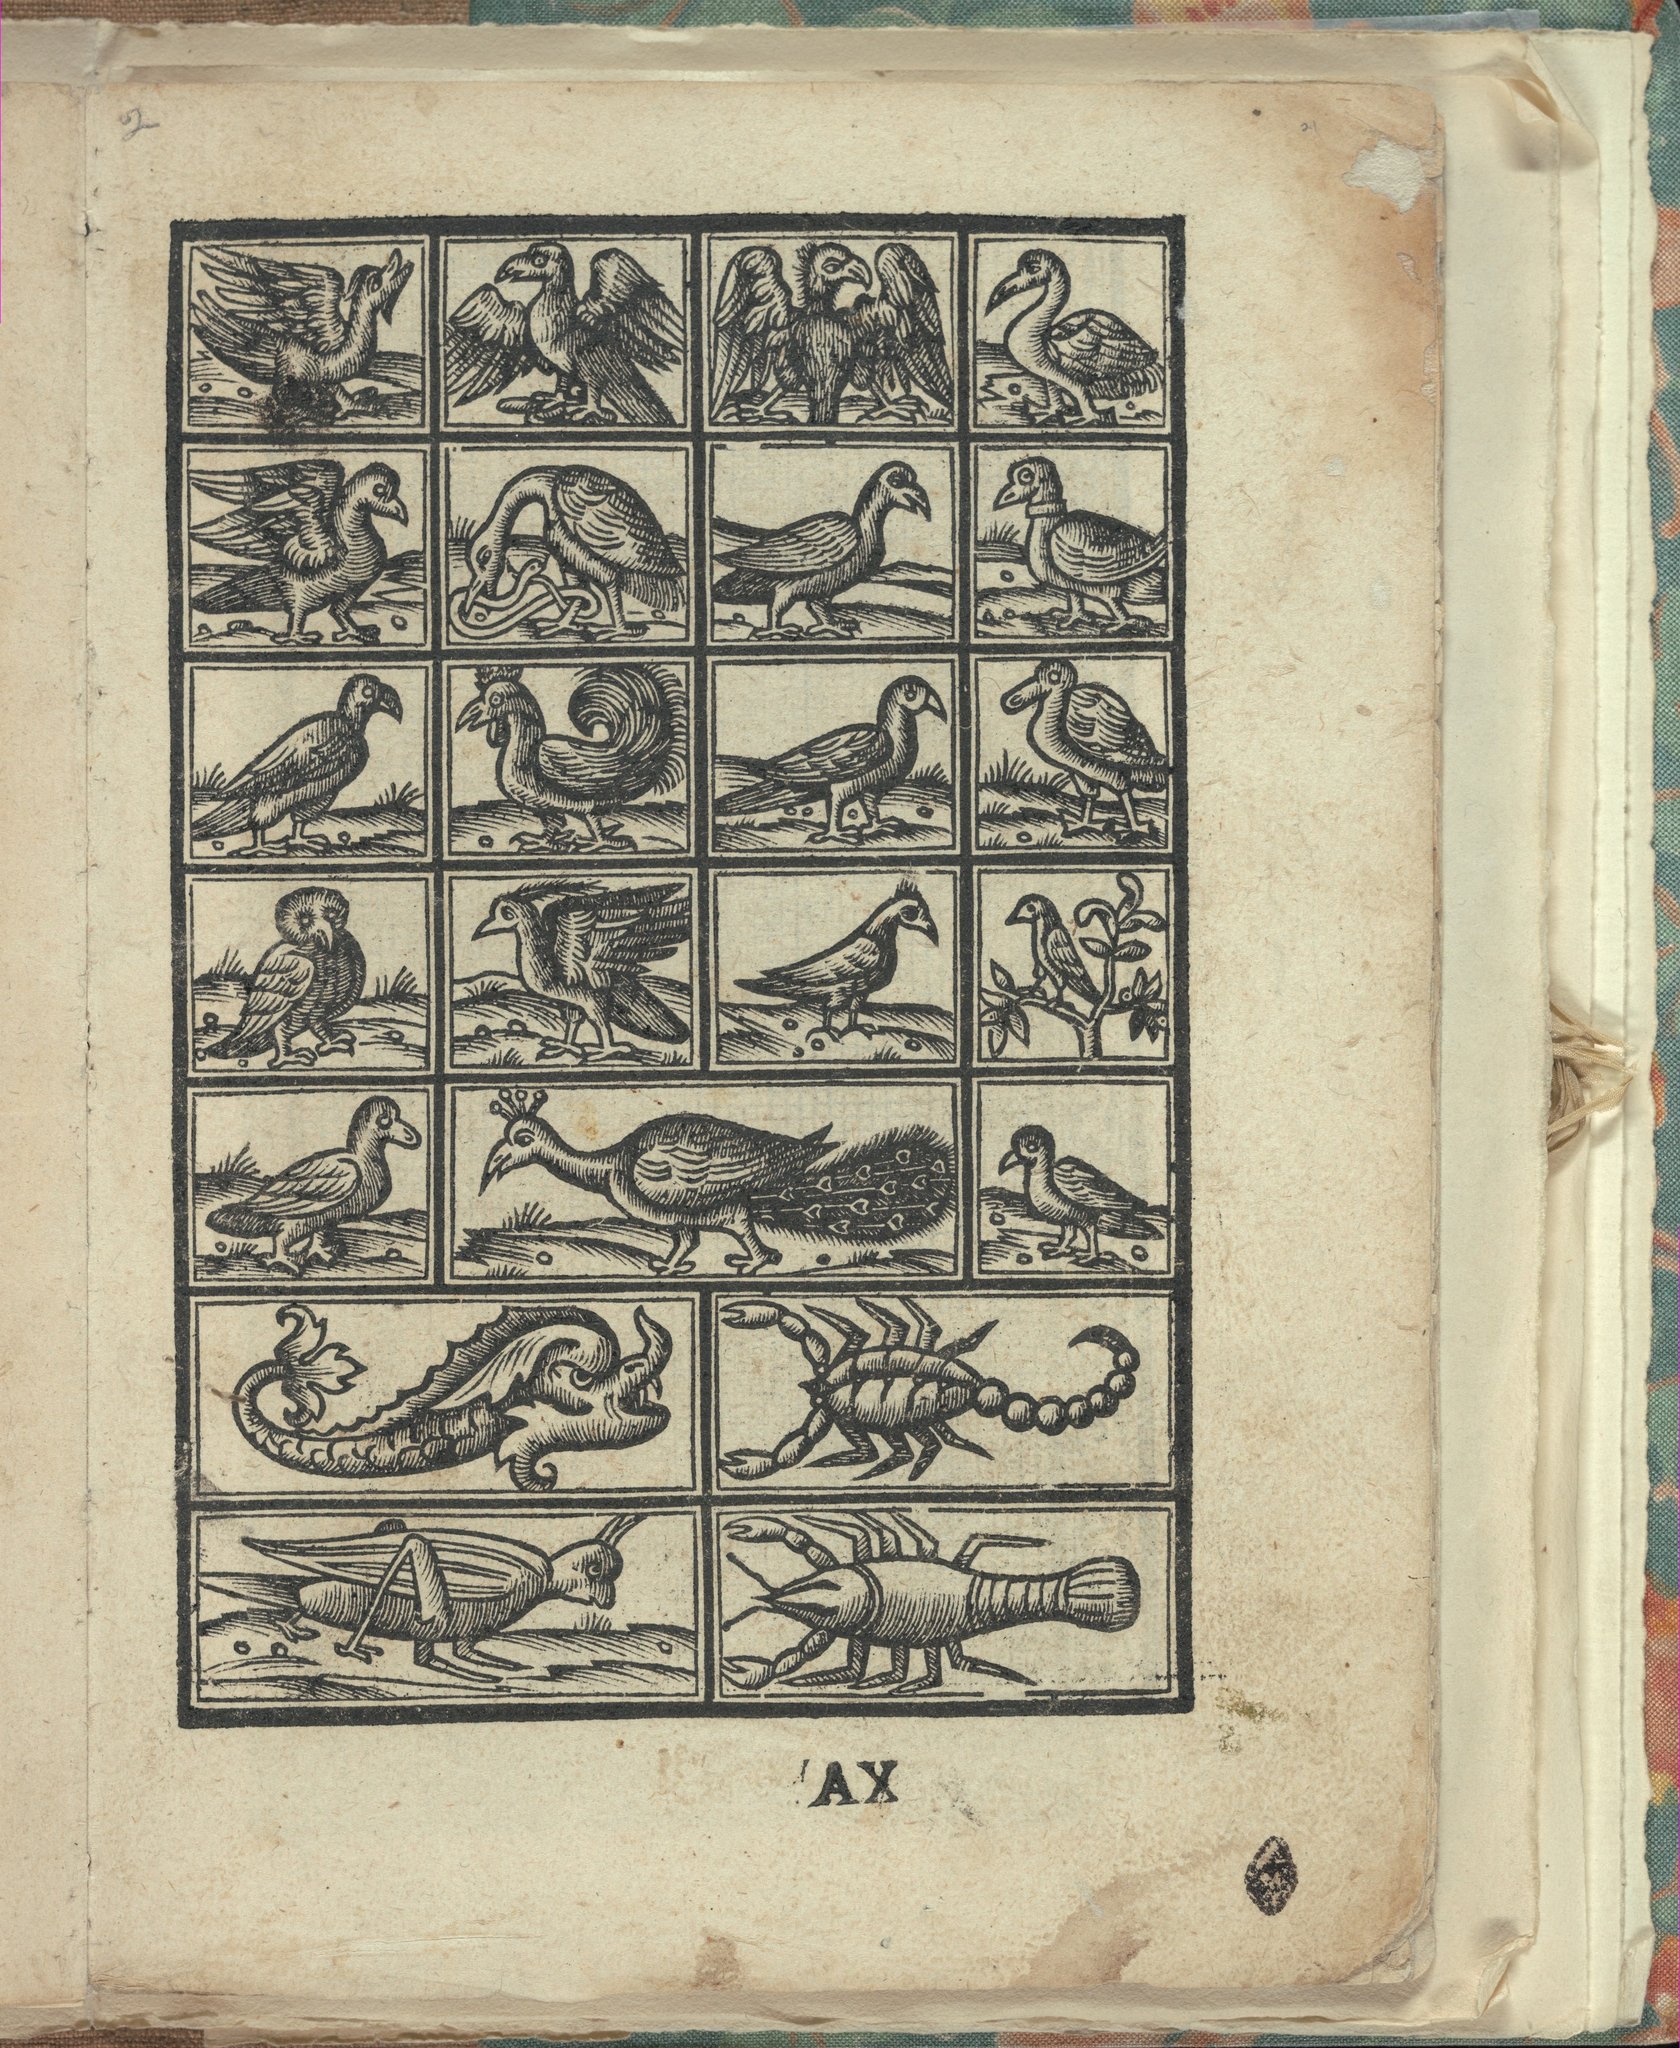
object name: book print ornament architecture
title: Opera Nova Universali intitulata Corona di racammi, page 21 (recto)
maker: giovanni andrea vavassore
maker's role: publisher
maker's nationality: italian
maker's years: 1530-1573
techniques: woodcut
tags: birds,peacocks,insects